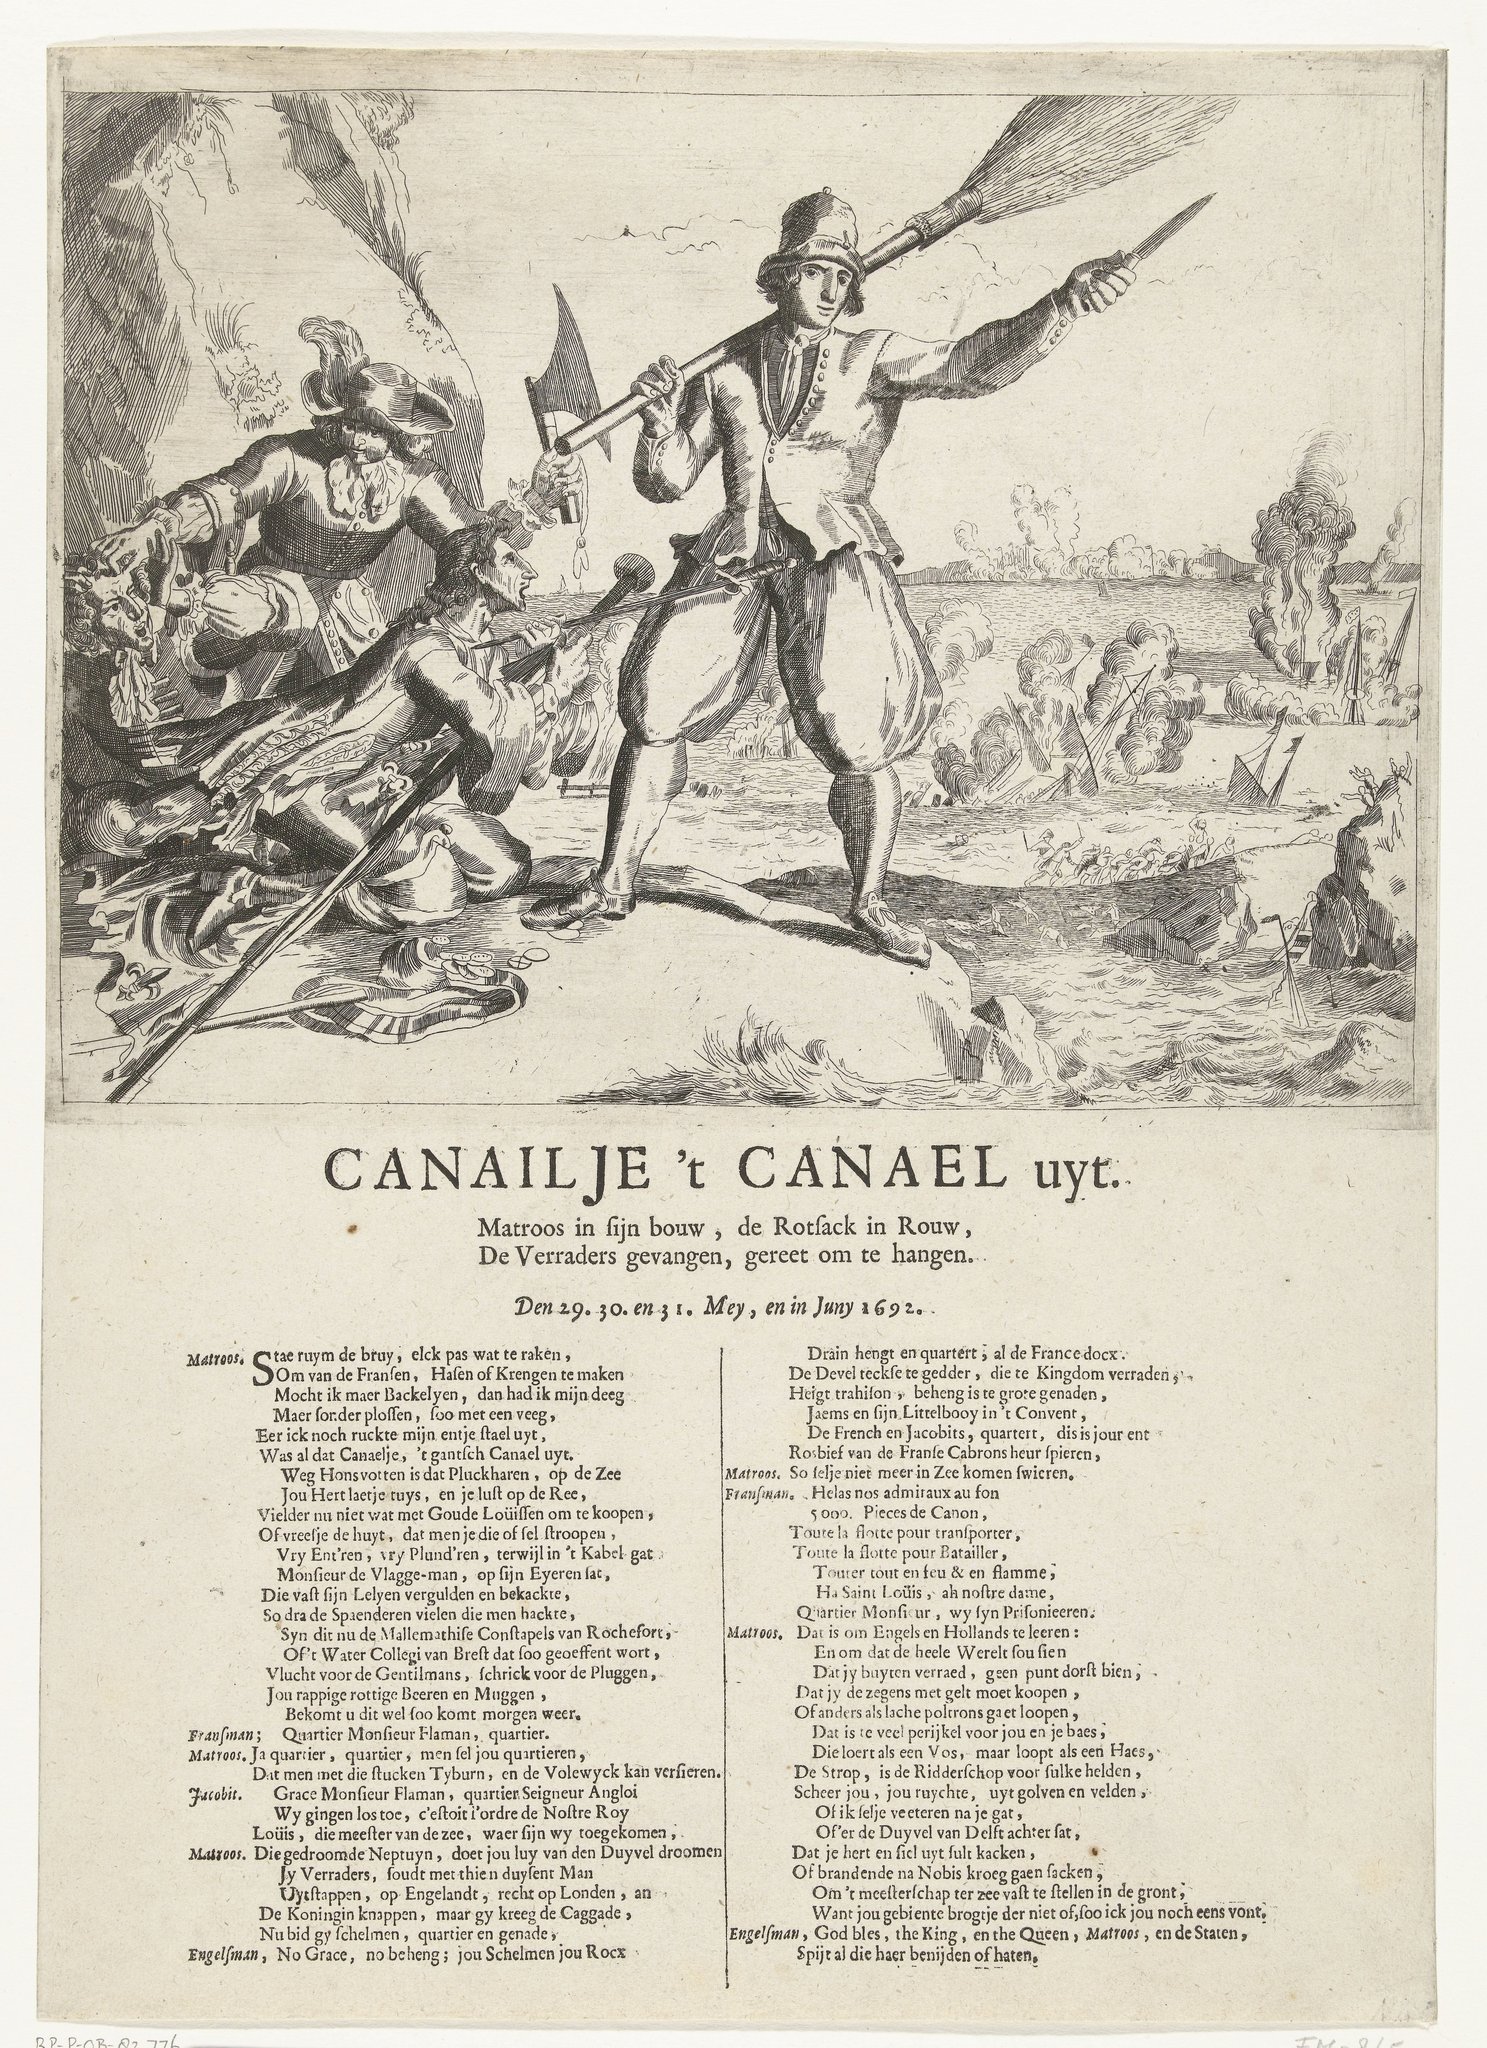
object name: cartoon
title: Spotprent op de Franse verliezen bij Kaap la Hogue, 1692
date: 1692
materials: paper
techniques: etching, letterpress printing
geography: northern netherlands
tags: political caricatures and satires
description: Spotprent op de verbranden van de Franse schepen door de Nederlanders en Engelsen na de overwinning in de slag bij Kaap la Hogue in het Kanaal, 29 mei t/m 3 juni 1692. De Hollandse Matroos met bezem en mes, aan zijn voeten een knielende smekende Fransman. Links dreigt een Engelsman een Jacobiet met een hakbijl. Met onderschrift in twee kolommen.